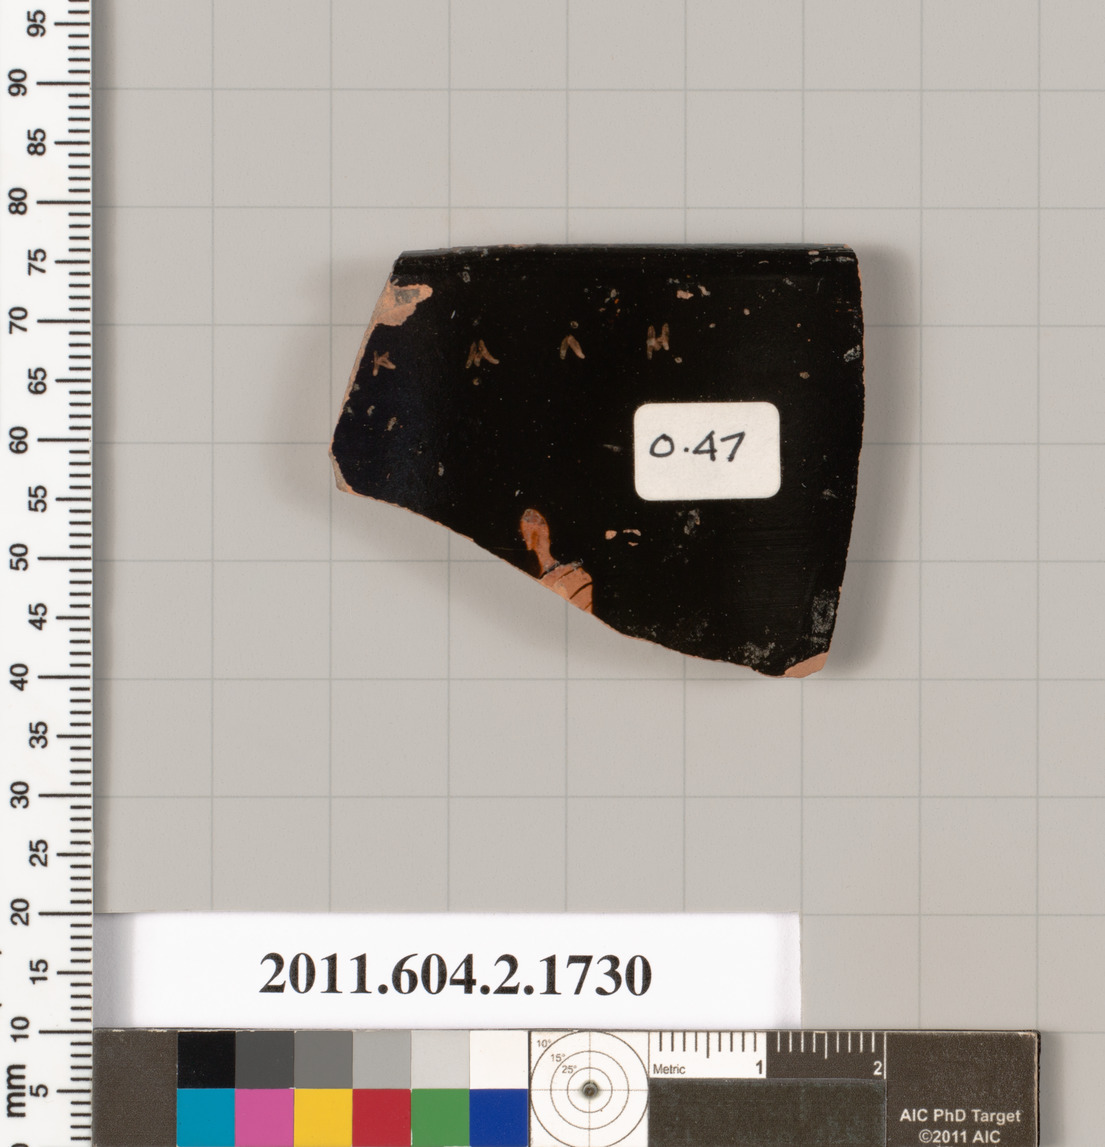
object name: skyphos fragment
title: Terracotta rim fragment of a skyphos (deep drinking cup)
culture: greek, attic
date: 475-451 BCE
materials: terracotta